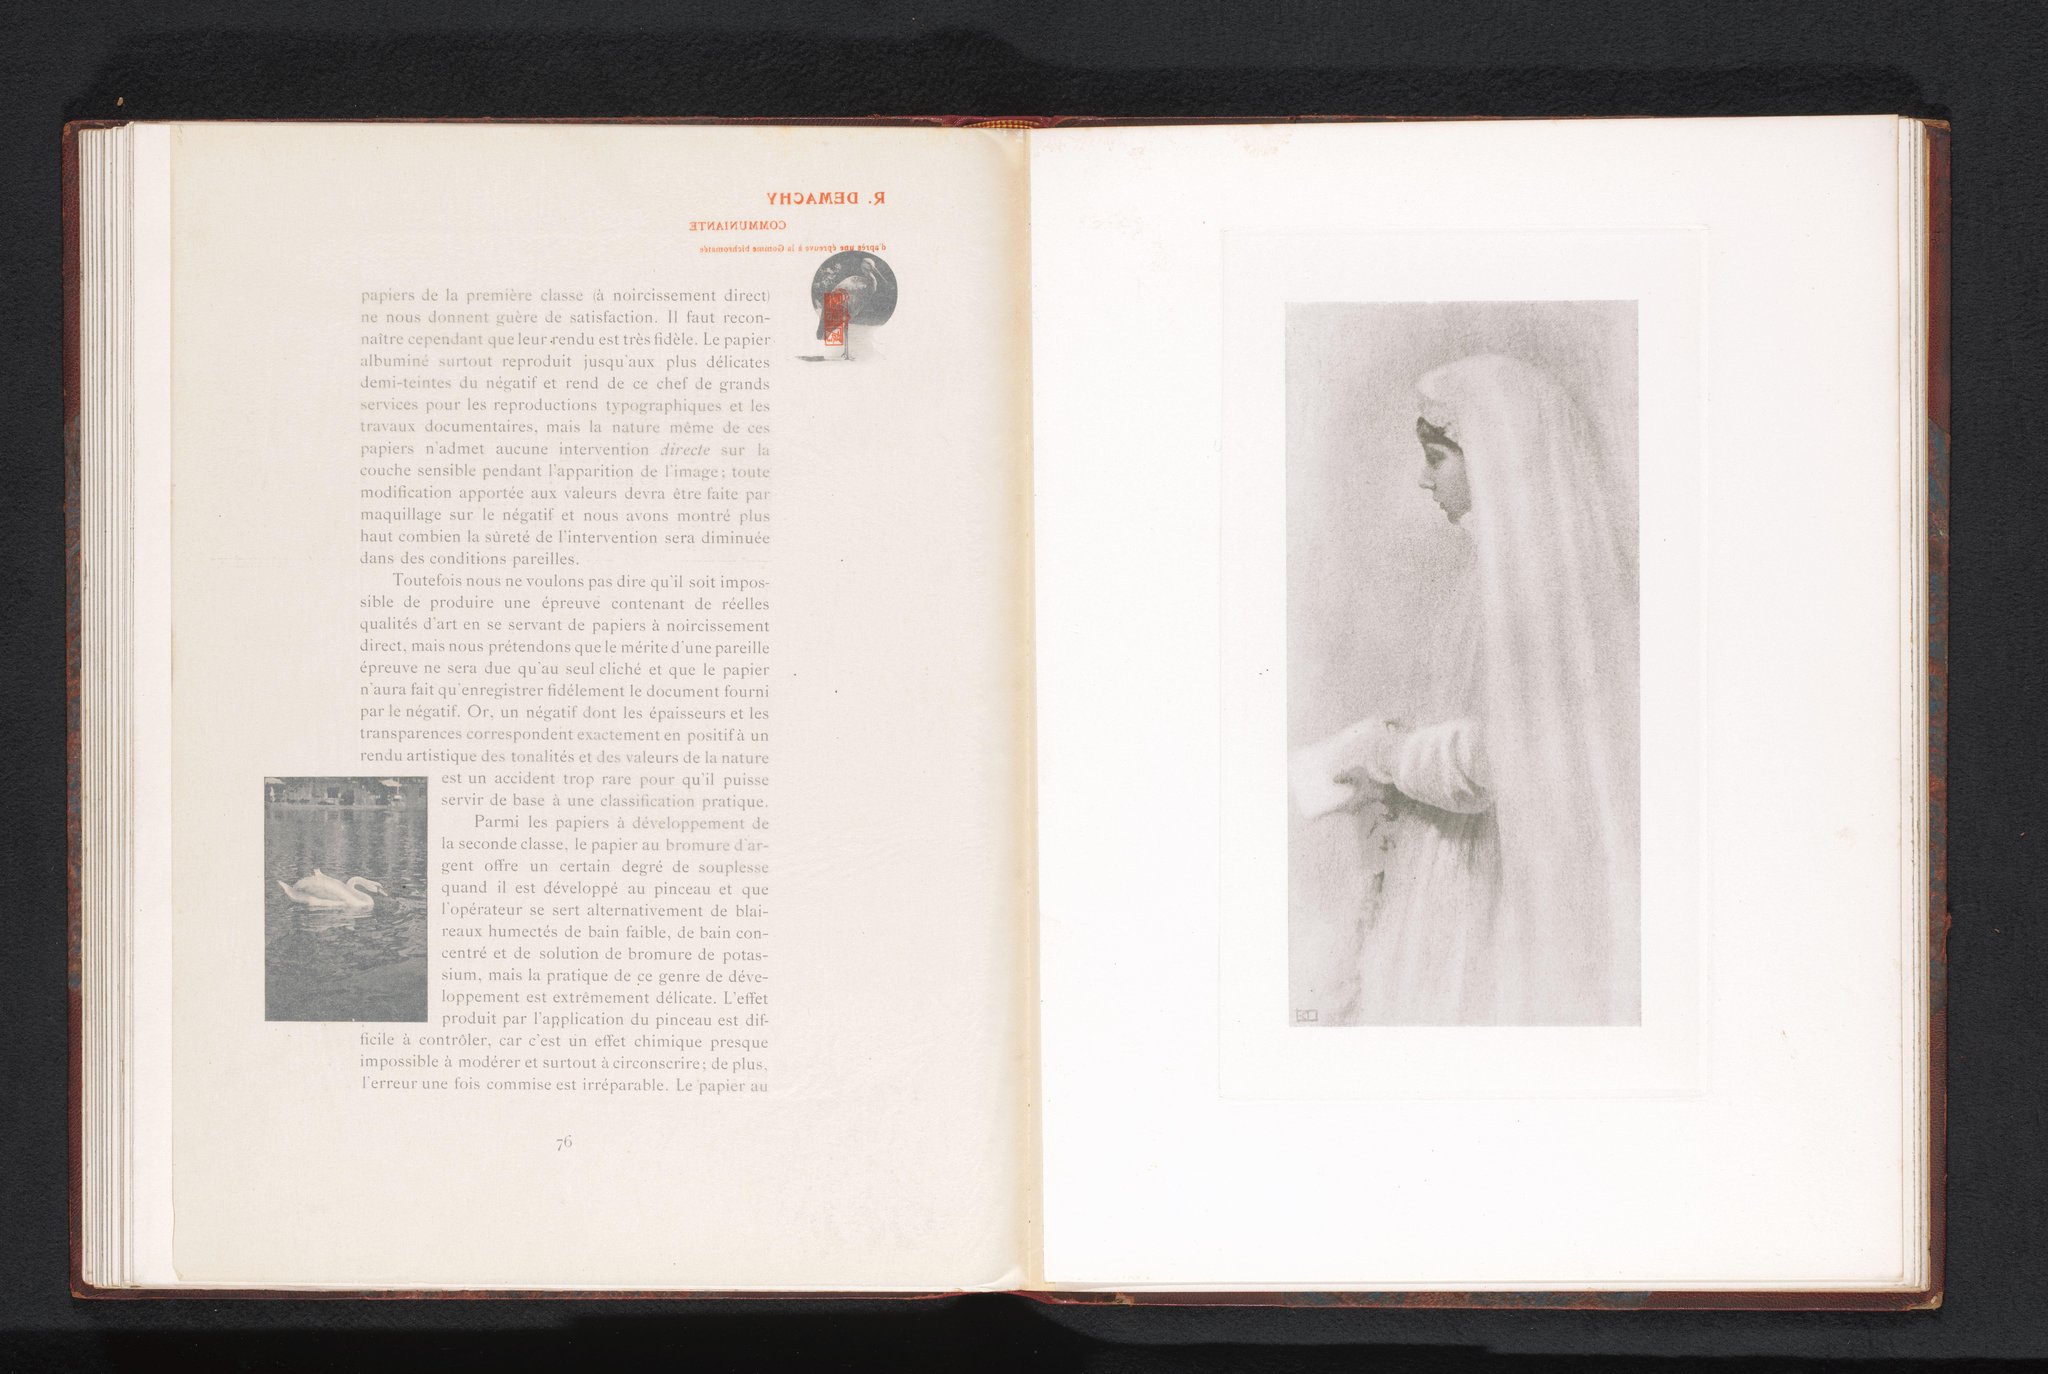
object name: page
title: Portret van een onbekende communicant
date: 1895-1900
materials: paper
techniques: autotype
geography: brussels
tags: first communicant